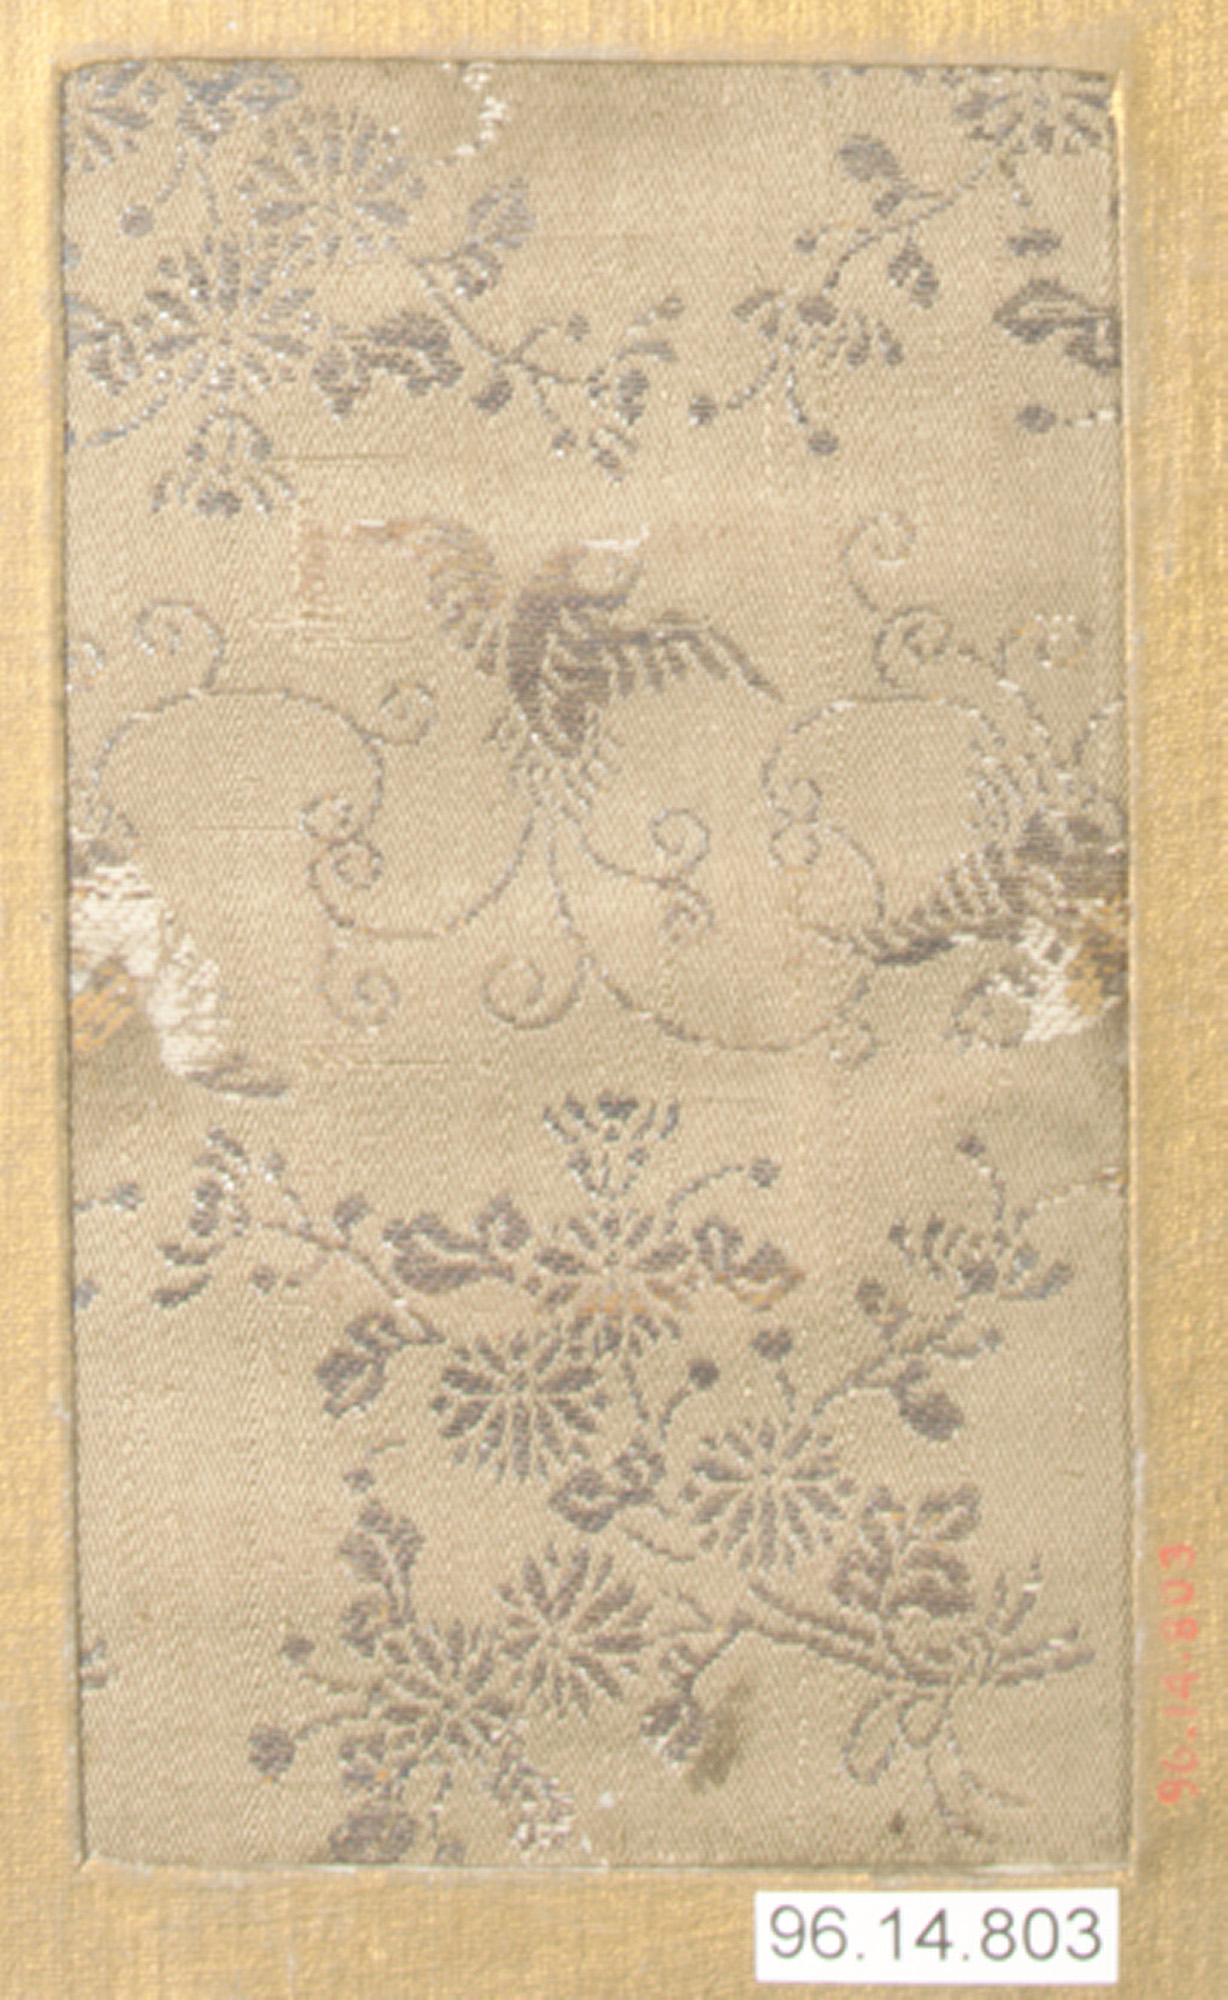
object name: piece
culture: japanese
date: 1701-1900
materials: silk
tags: leaves